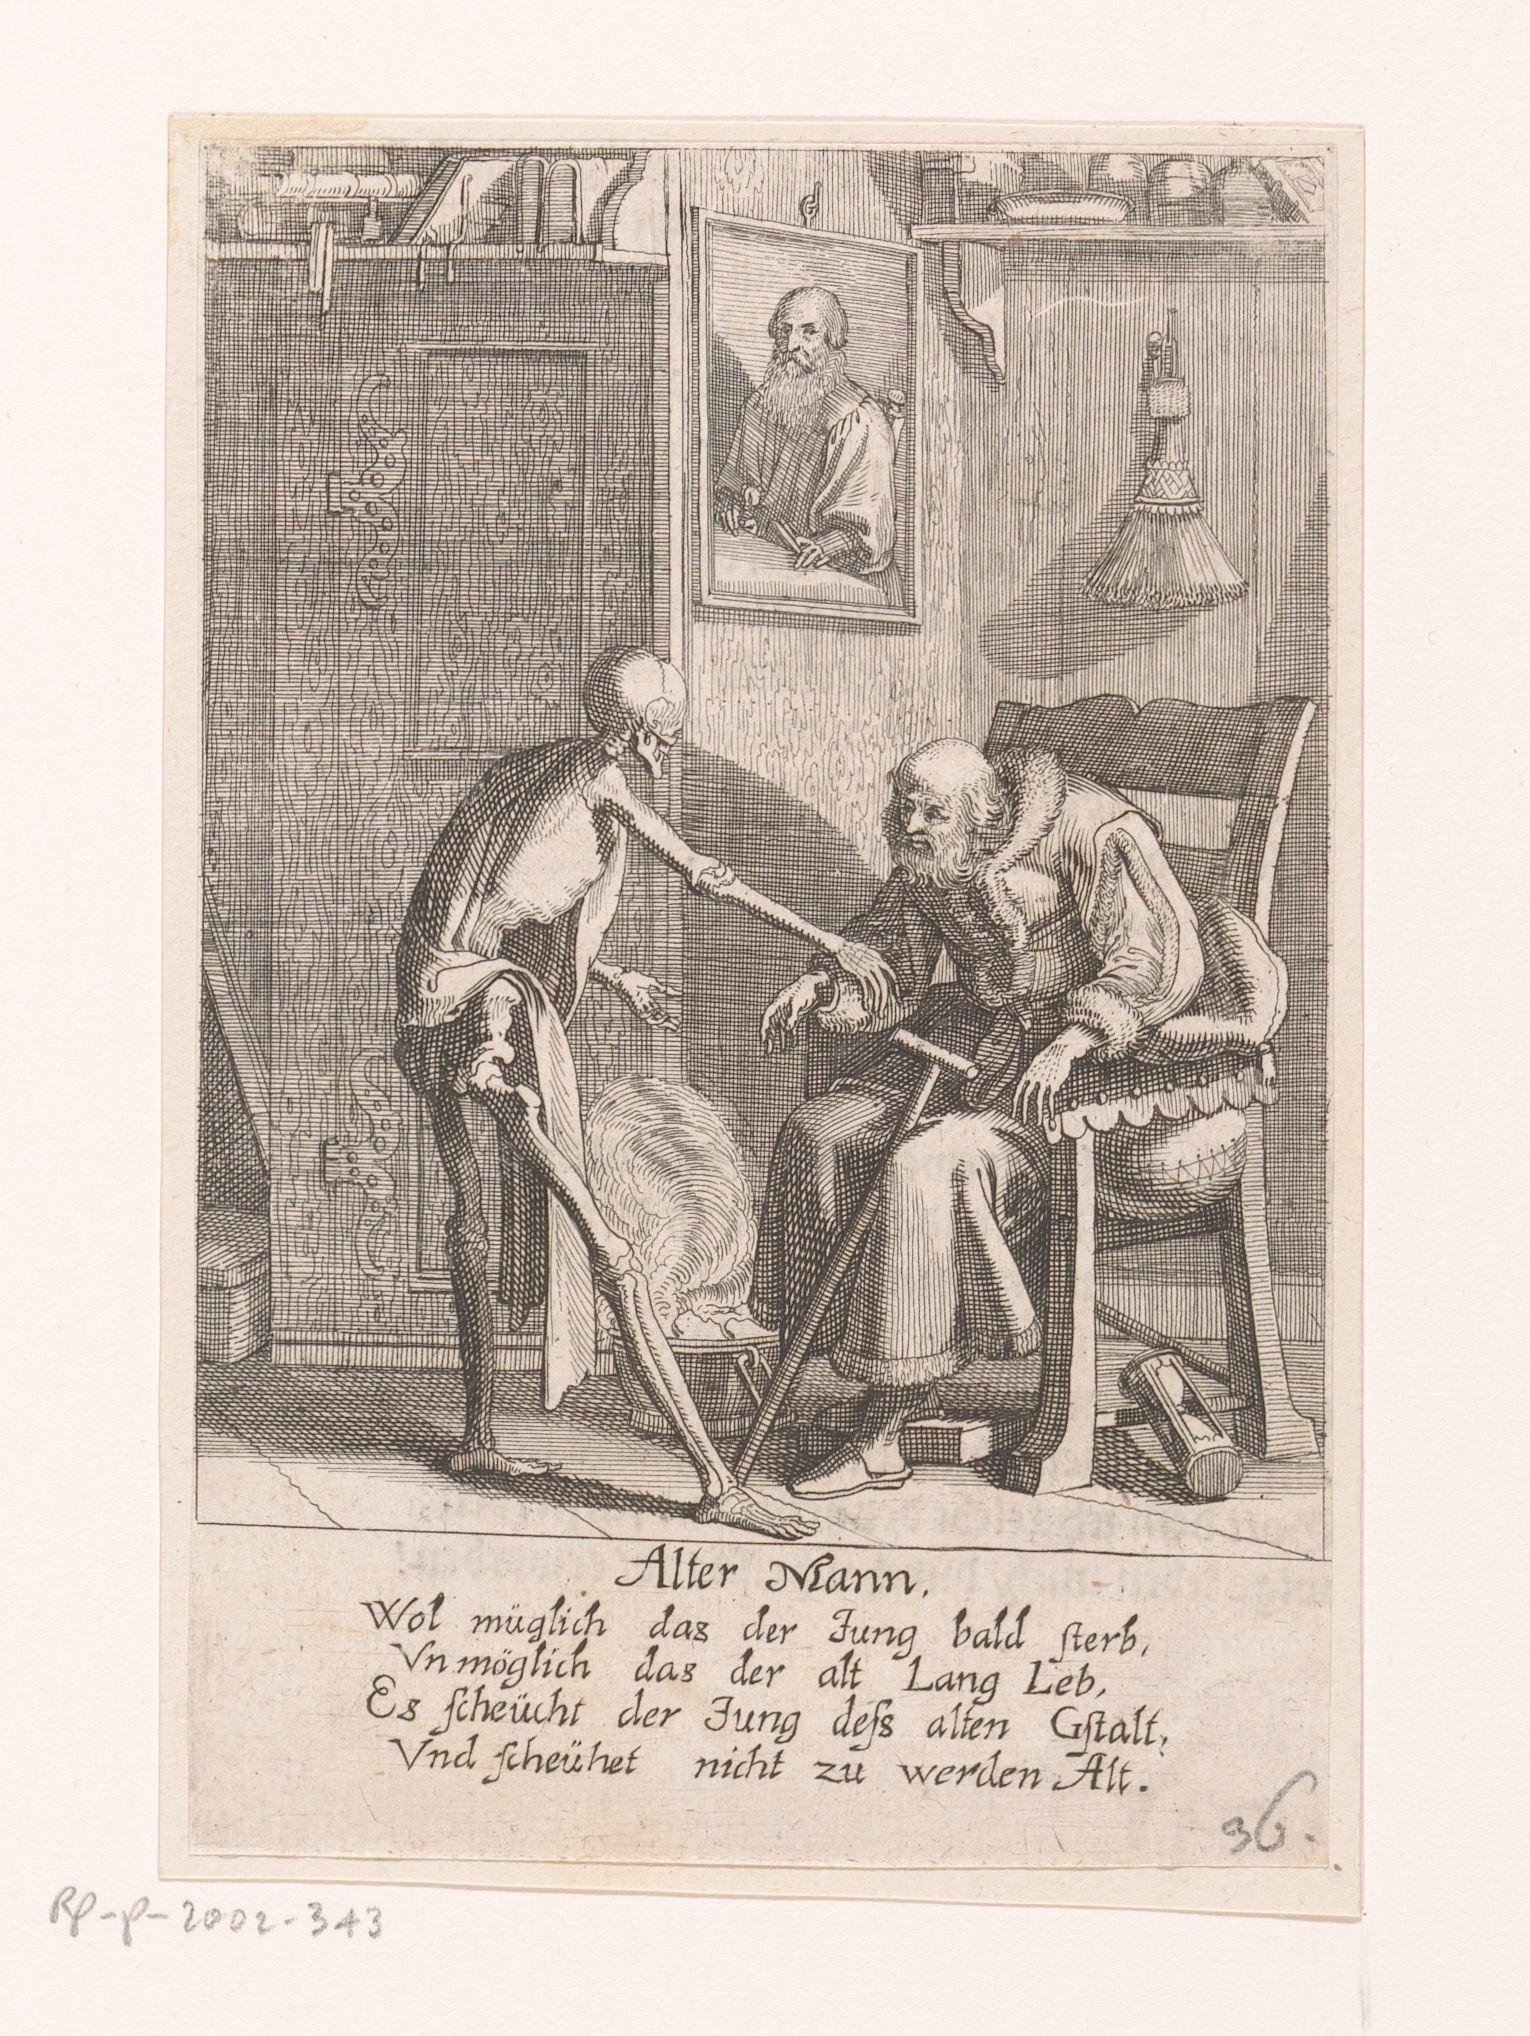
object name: book illustration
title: Alter Mann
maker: johann jakob bodmer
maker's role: printer, publisher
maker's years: 1629-1650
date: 1650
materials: paper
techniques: etching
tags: personifications of death; 'morte' (ripa), dance of death; death together with one or more human beings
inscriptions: collector's mark: Lugt 2228, collector's mark: Lugt 2233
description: Prent uit: Meyer, Rudolph. Sterbenspiegel, das ist sonnenklare Vorstellung menschlicher Nichtigkeit durch alle Ständ und Geschlechter (...). Zürich: J.J. Bodmer, 1650.